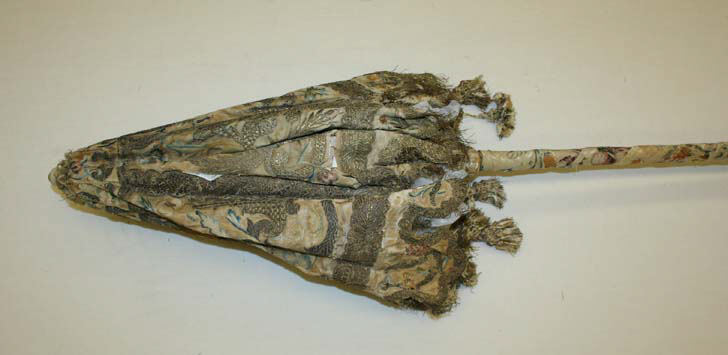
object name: parasol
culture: italian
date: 1701-1800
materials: metal, silk, wood